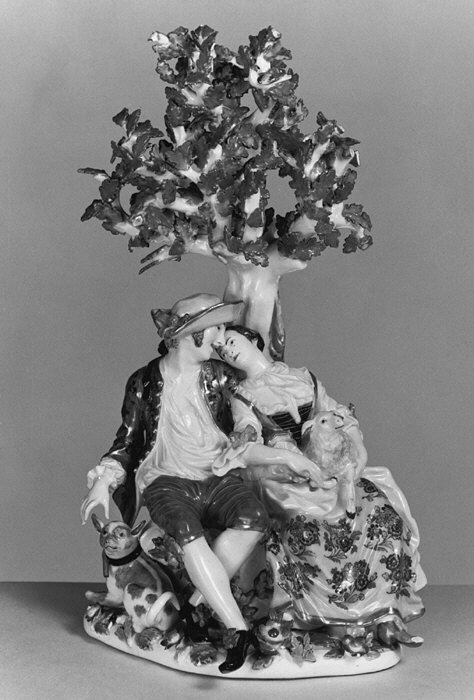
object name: group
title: Shepherd lovers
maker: meissen manufactory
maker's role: manufactory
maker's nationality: german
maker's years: 1710-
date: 1742-1745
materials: hard paste porcelain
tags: lovers,sheep,trees,shepherds